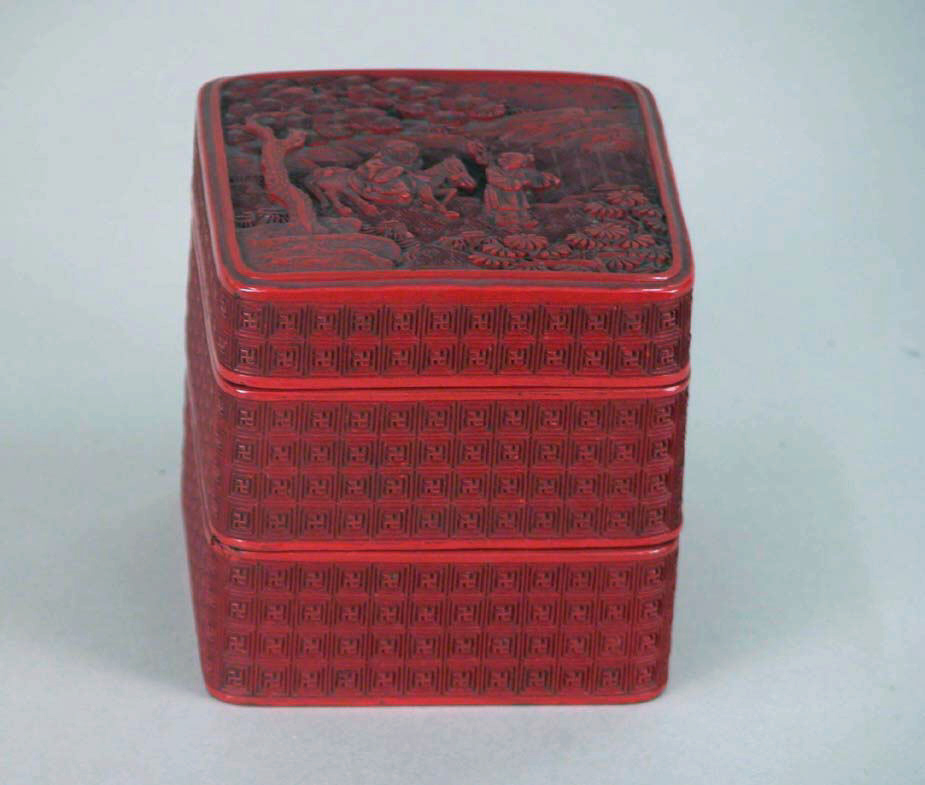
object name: box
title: Tiered Box with Figures in a Landscape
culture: chinese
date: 1701-1800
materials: lacquer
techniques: carving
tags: human figures,trees